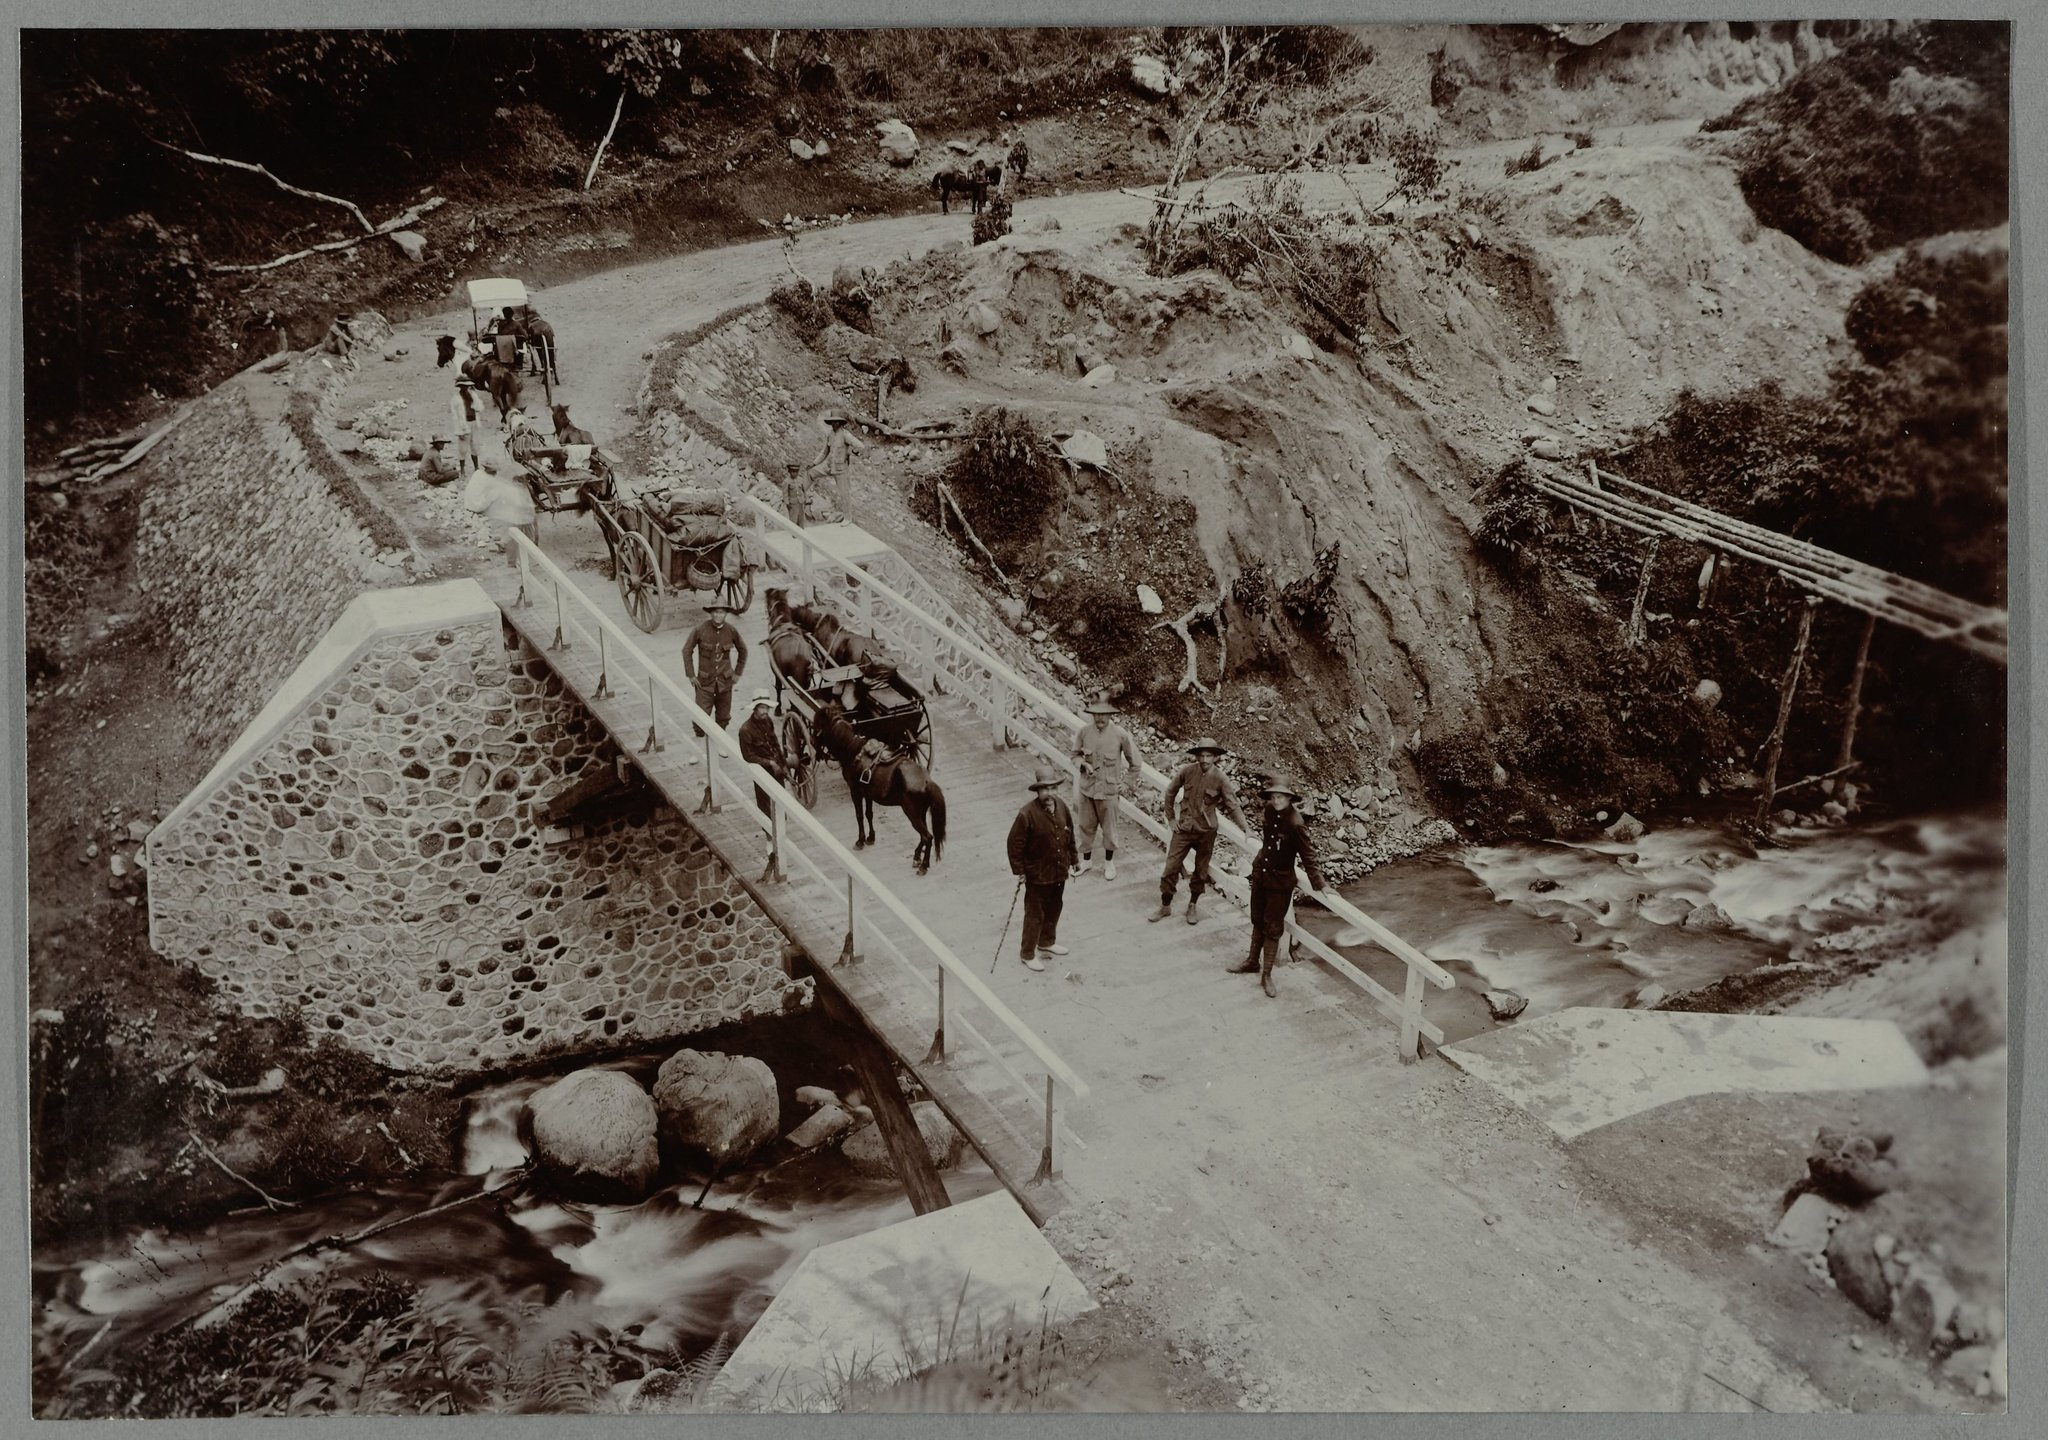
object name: photograph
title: Nieuwe brug over de Wenih Rongka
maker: Anonymous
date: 1903-1913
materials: photographic support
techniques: photography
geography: north sumatra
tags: arnhem, the hague, albertus dominicus laman trip, landscapes in tropical and sub-tropical regions, bridge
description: Na de expedities naar de Gajo- en Alaslanden o.l.v. Van Daalen (eerste tocht in 1901), werd hij in 1903 belast met voorbereiding van permanente vestiging van Nederlands gezag. Aanleg van een weg van de Noordkust naar het binnenland was hierbij van groot belang. Deze zgn. Gajoweg werd aangelegd tussen 1903 en 1914, van Bireuen aan de kust naar Takinguen aan het bergmeer Danau Lauttawar, totale lente 104 km.